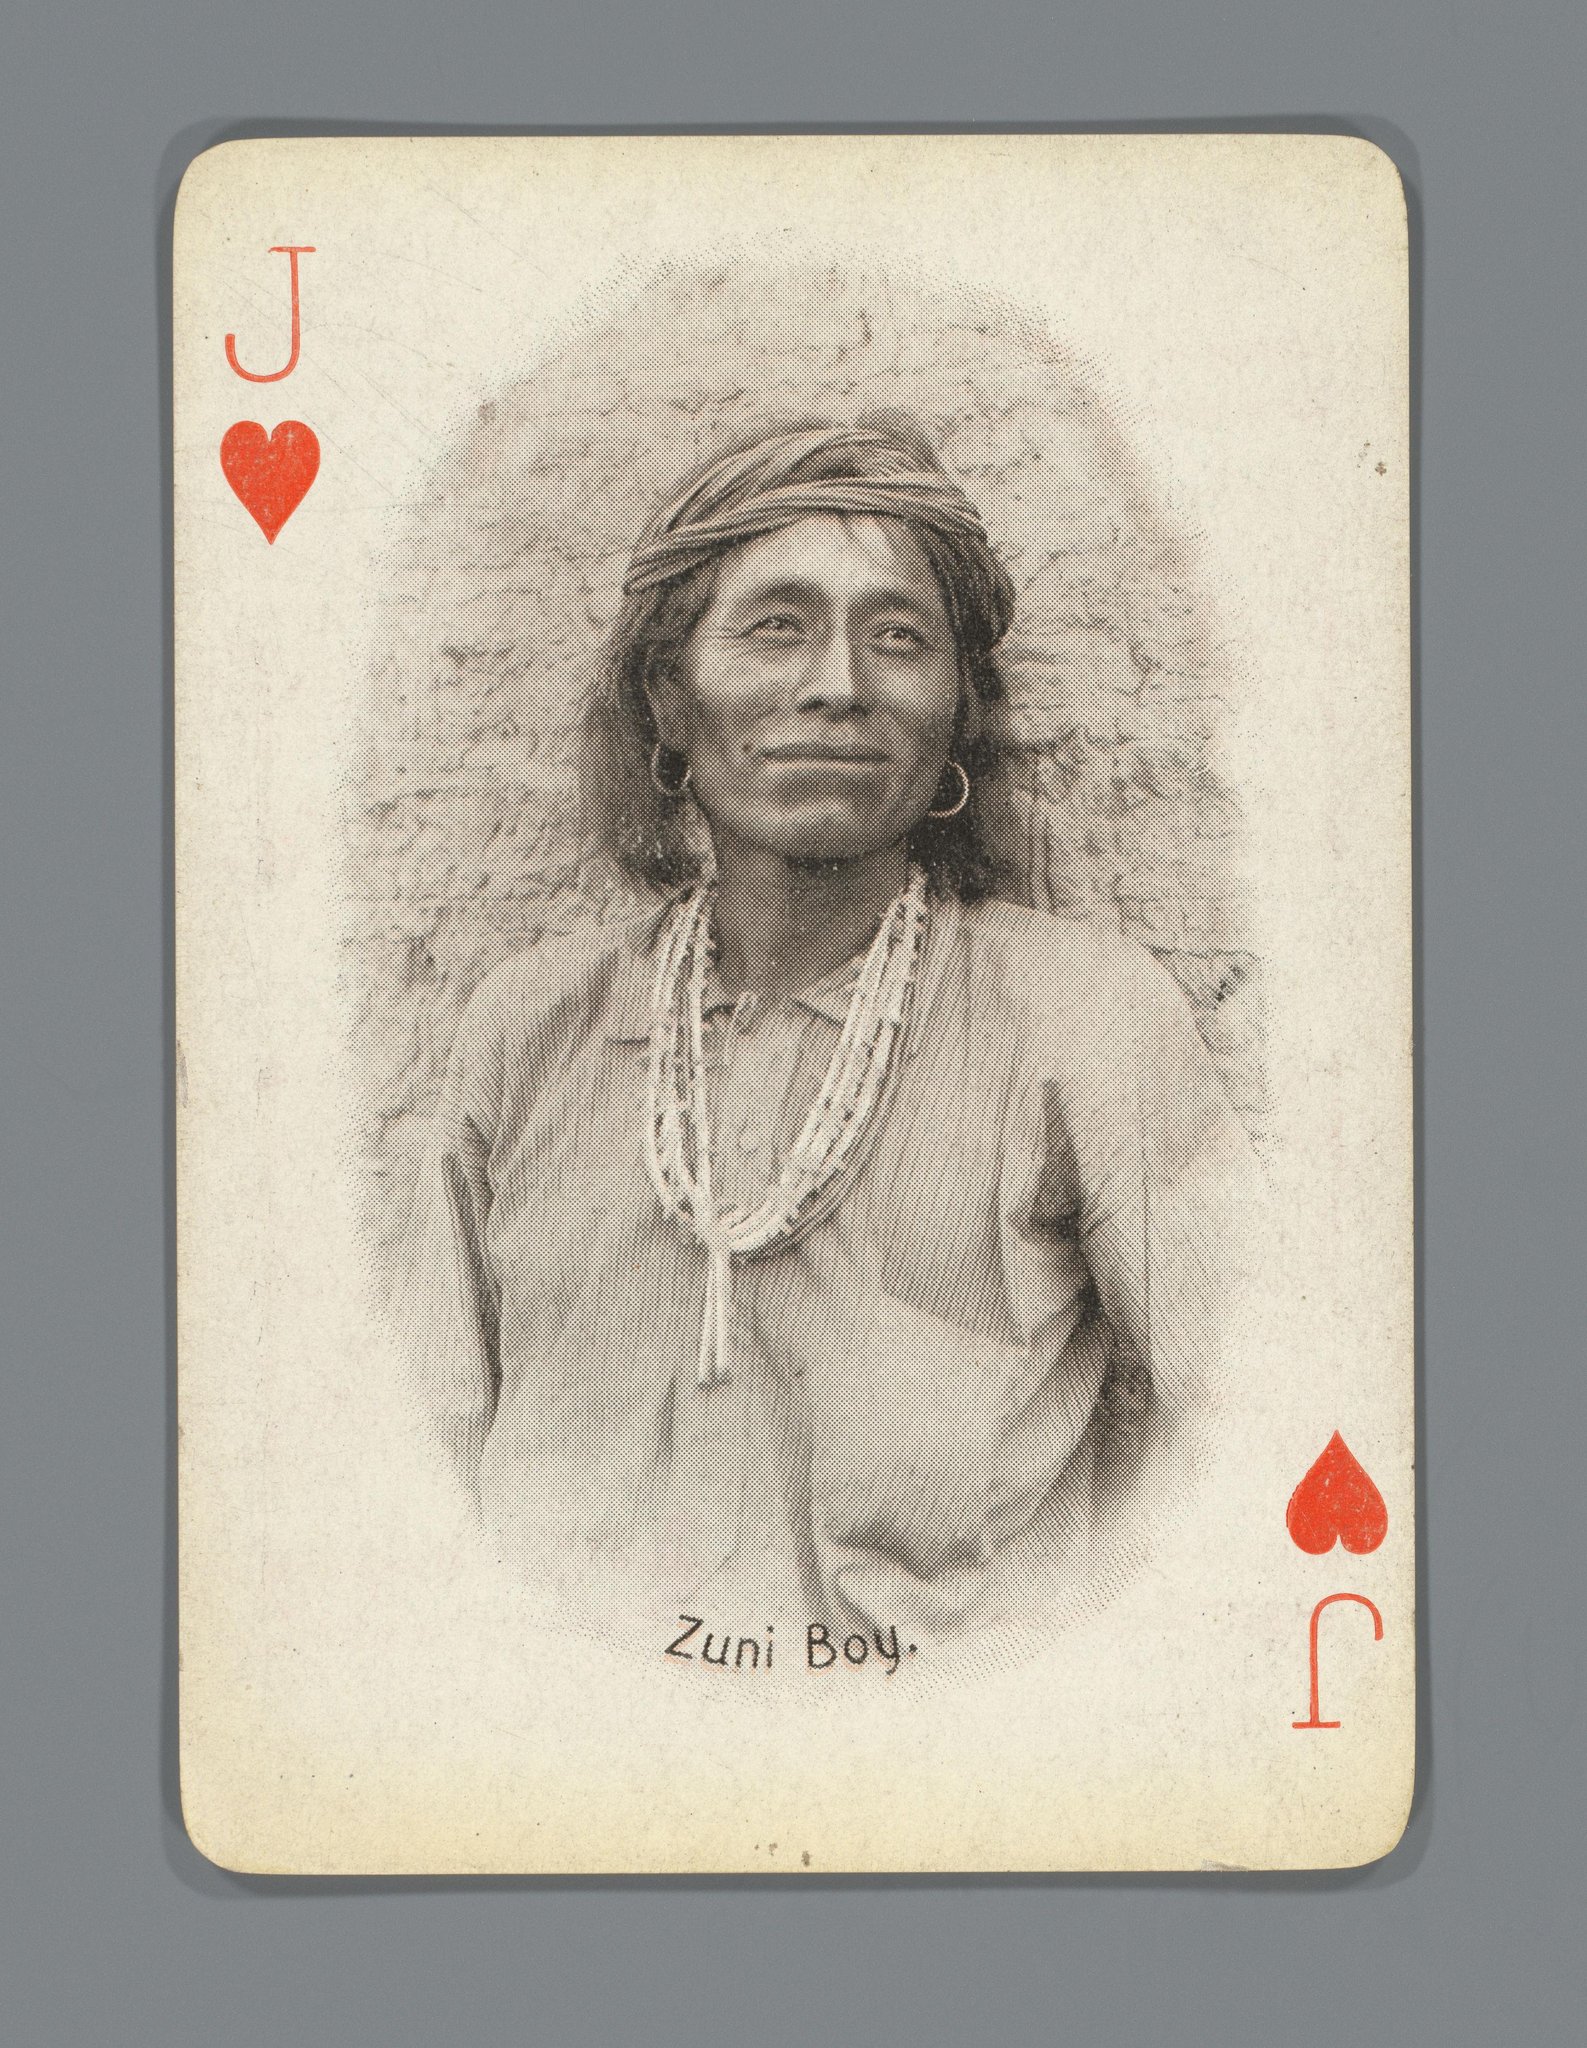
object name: photograph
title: Harten boer met portret van een Zunijongen uit Moki, New Mexico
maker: adam clark vroman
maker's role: fotograaf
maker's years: 1856-1916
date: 1900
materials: paper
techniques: autotype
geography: los angeles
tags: new mexico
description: Speelkaart uit doosje met 53 speelkaarten met afbeeldingen in autotypie van Native Americans. De inhoud bevat een complete set speelkaarten inclusief joker.